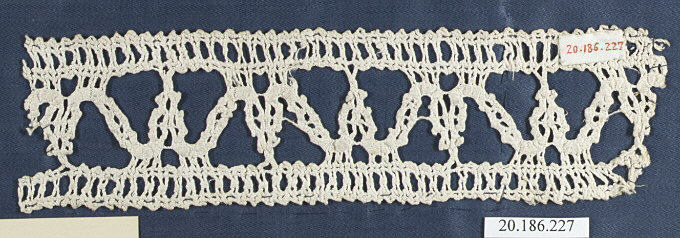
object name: insertion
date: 1501-1700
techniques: lace